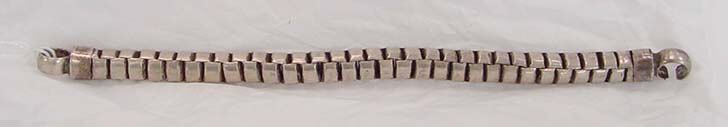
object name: bracelet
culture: indian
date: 1801-1900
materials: metal